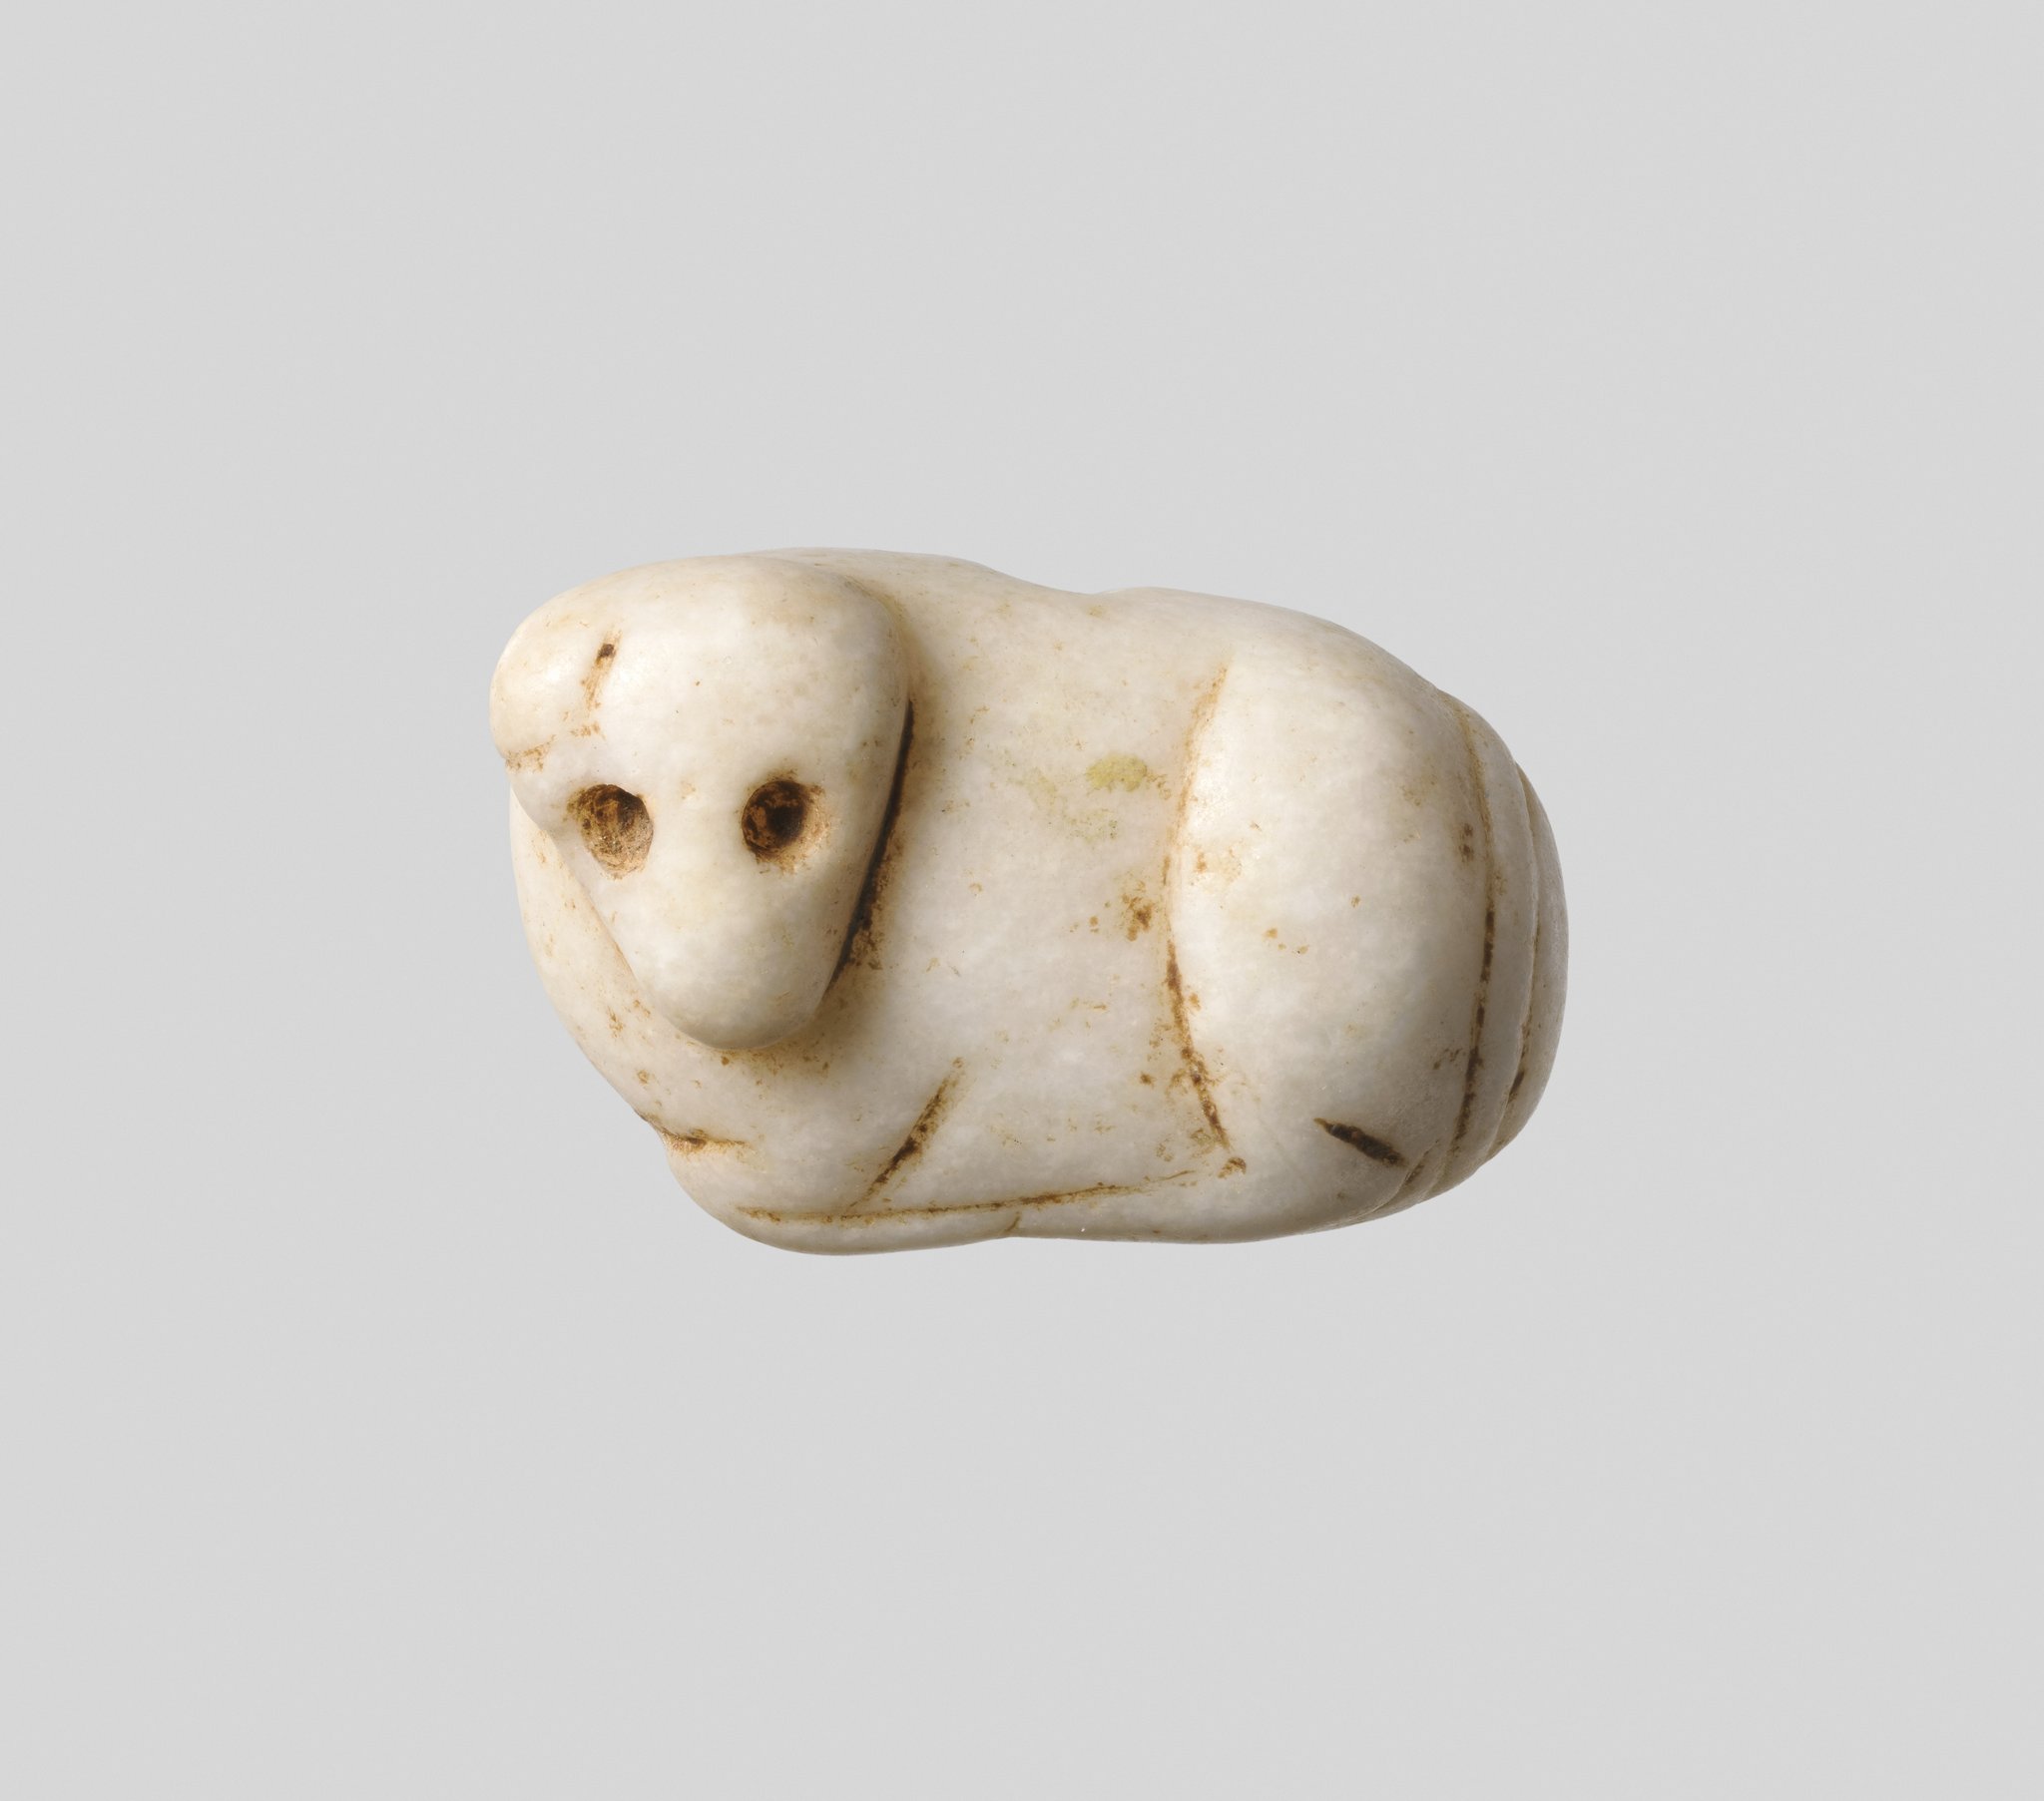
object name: stamp seal amulet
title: Seal amulet in the form of a recumbent bovid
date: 3500-2900 BCE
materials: marble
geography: iran or mesopotamia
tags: animals